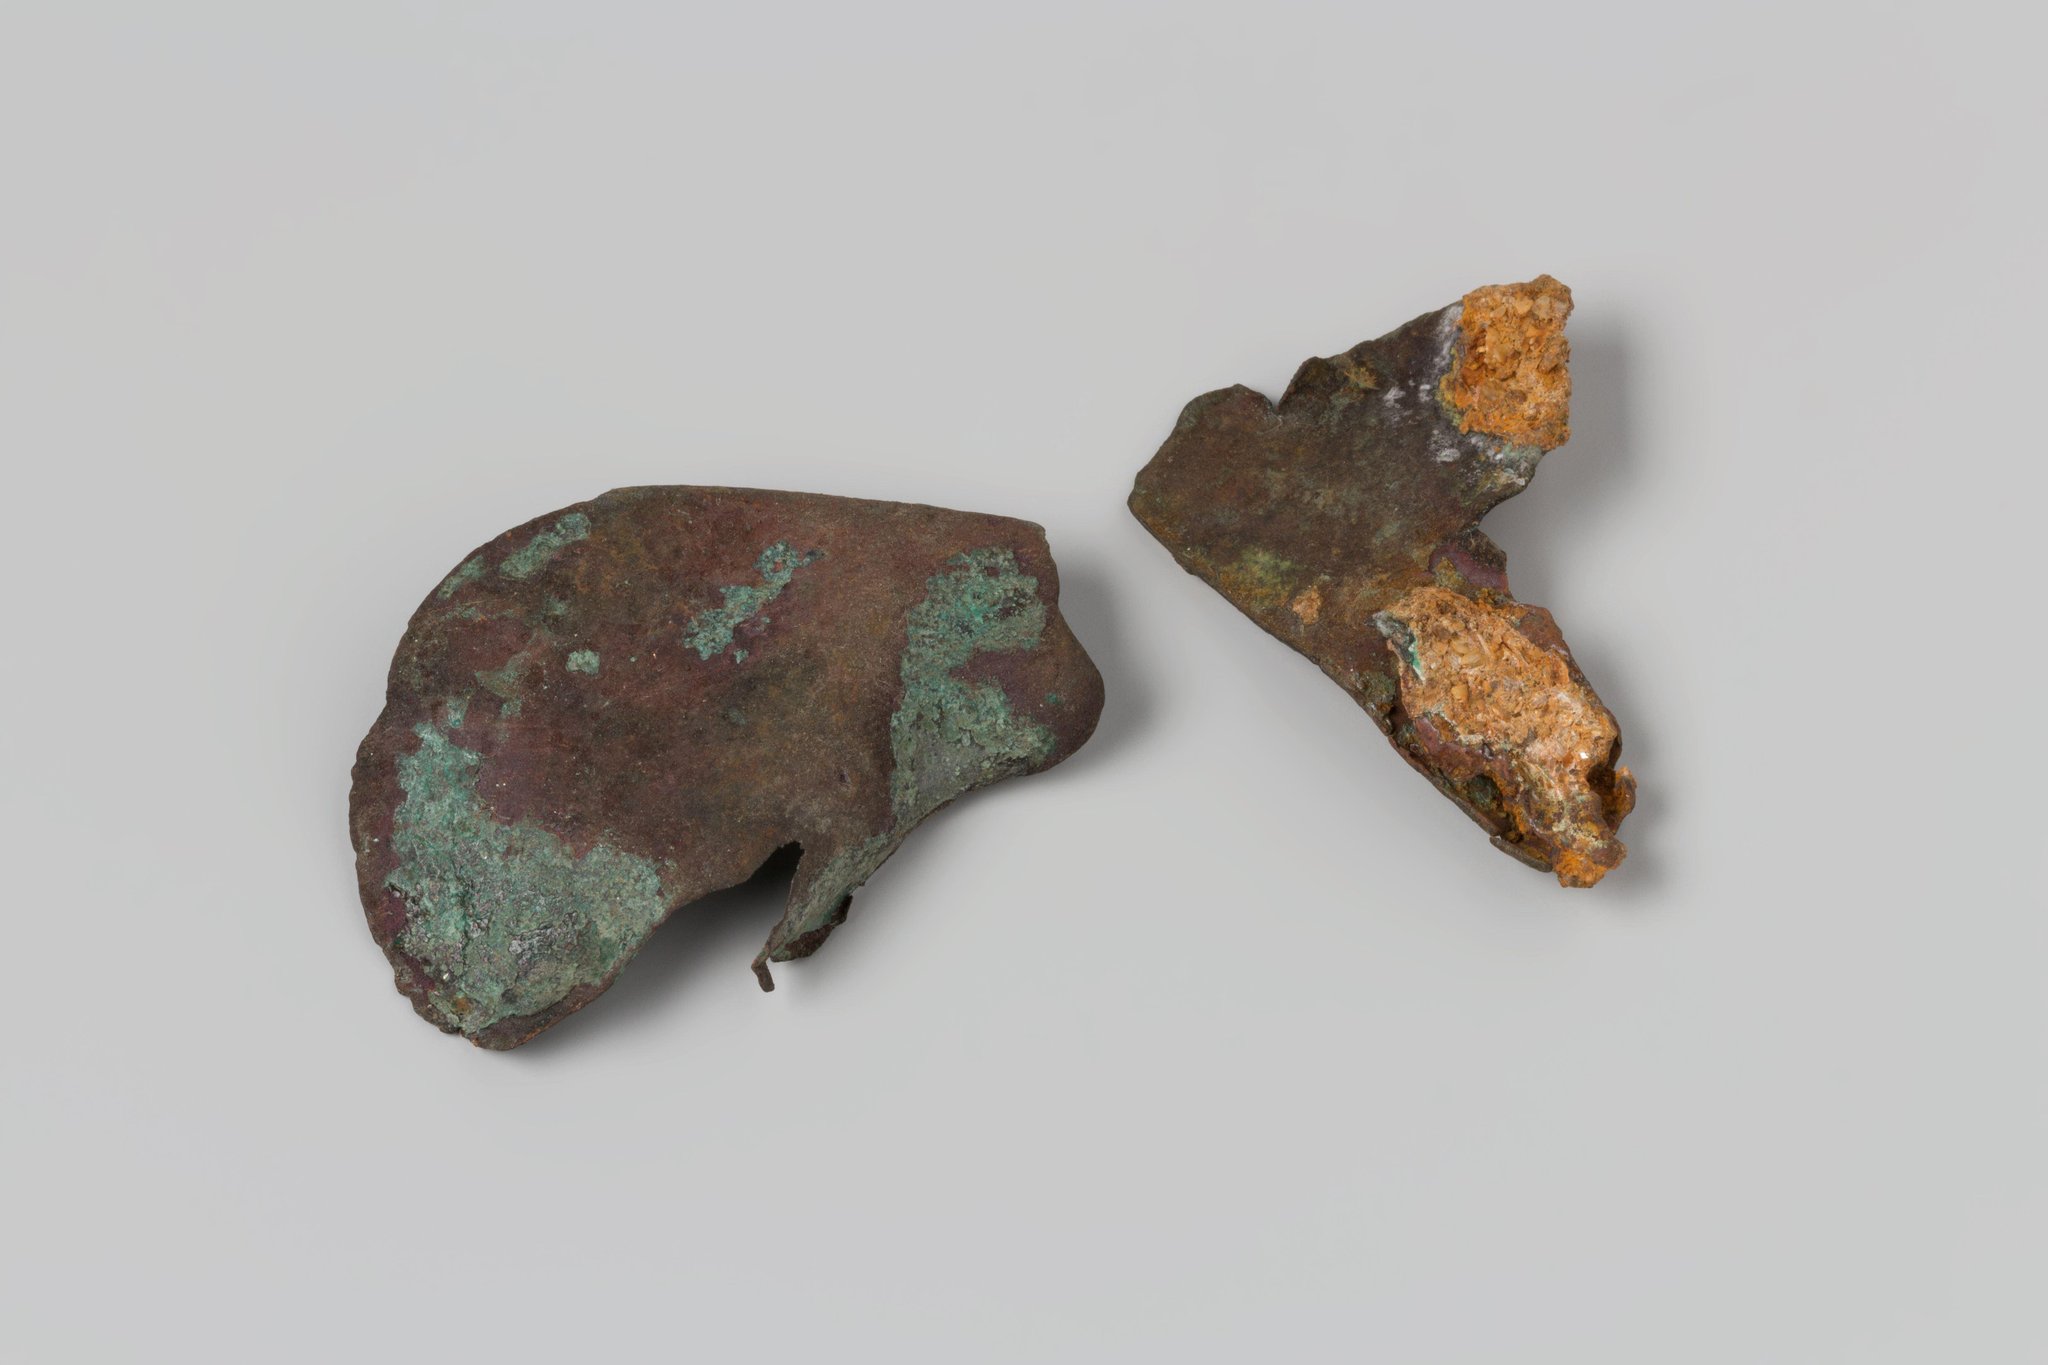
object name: scheepswrakvondst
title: Fragmenten van koper uit het wrak van de Oost-Indiëvaarder Hollandia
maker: Anonymous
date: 1700-1743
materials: copper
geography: netherlands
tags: verenigde oostindische compagnie, hollandia (schip), annet